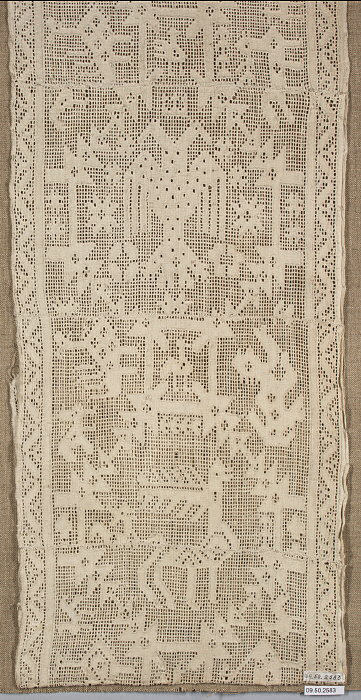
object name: drawnwork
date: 1501-1700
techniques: embroidery